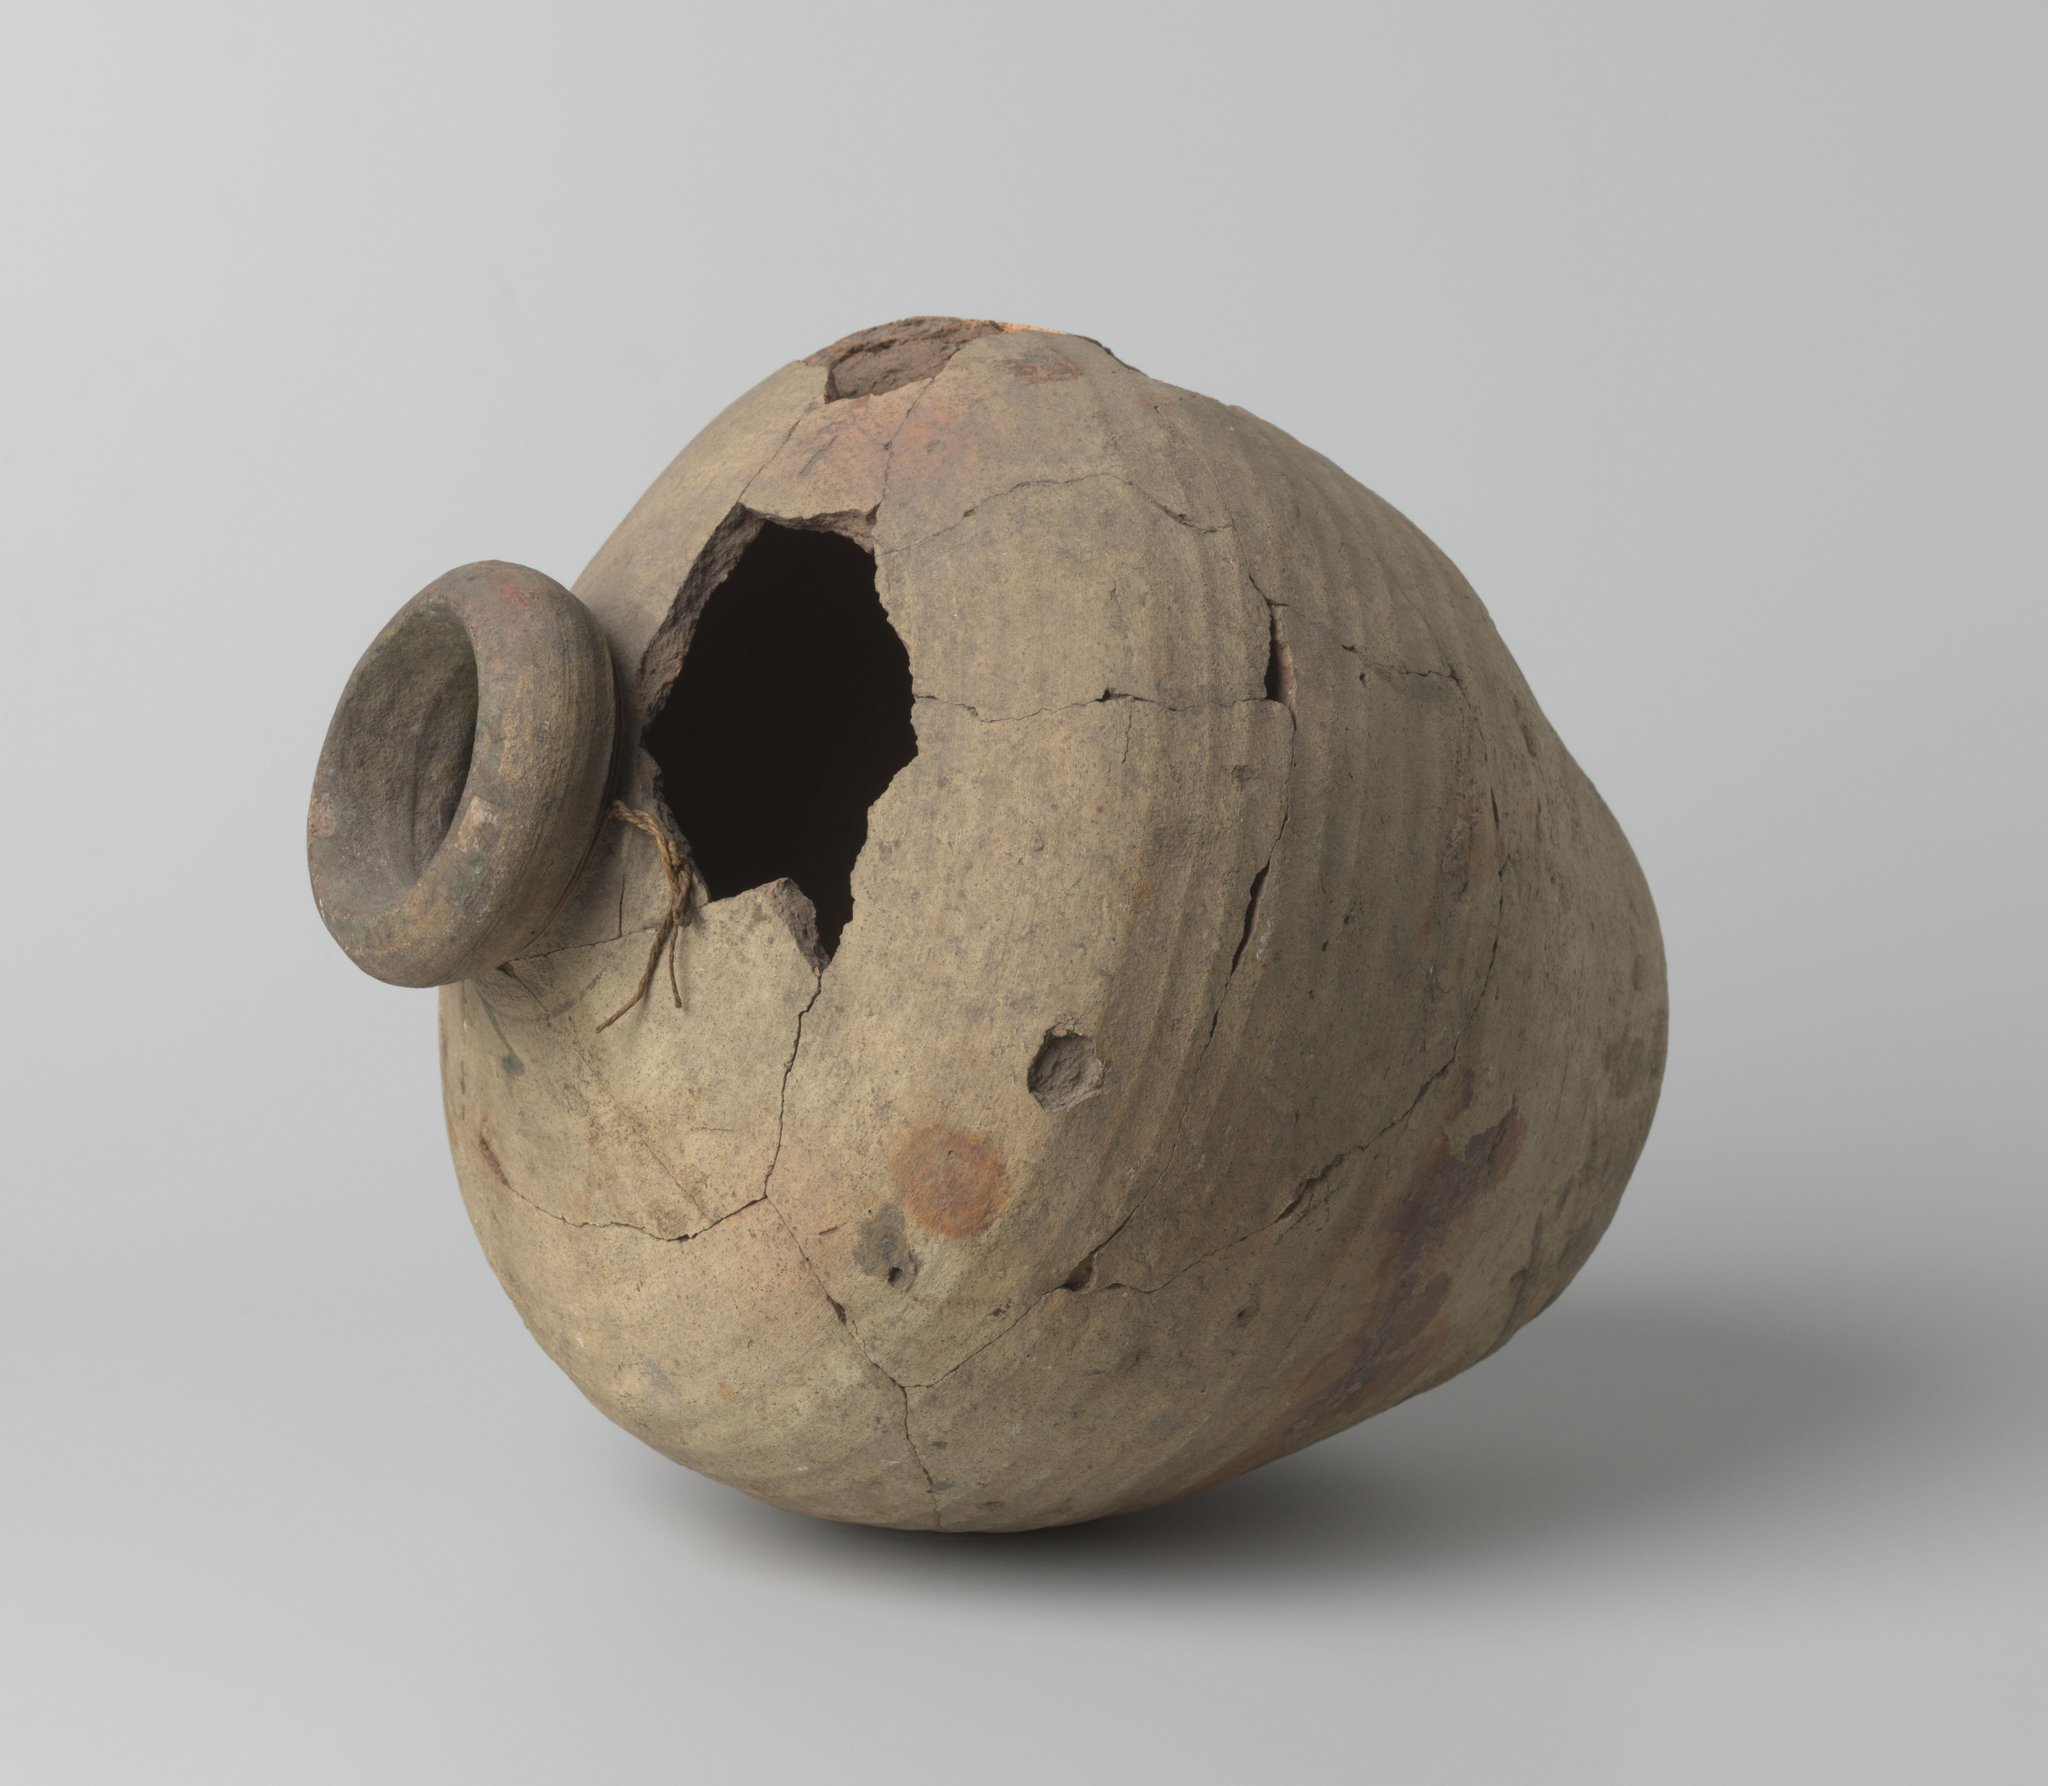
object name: urn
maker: Anonymous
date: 1400-1950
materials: earthenware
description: Urn aan onderzijde toelopend. Breed geschouderd waaronder tapstoelopend geribde wand. Dikke rand om de mond van de pot. Geen standring.